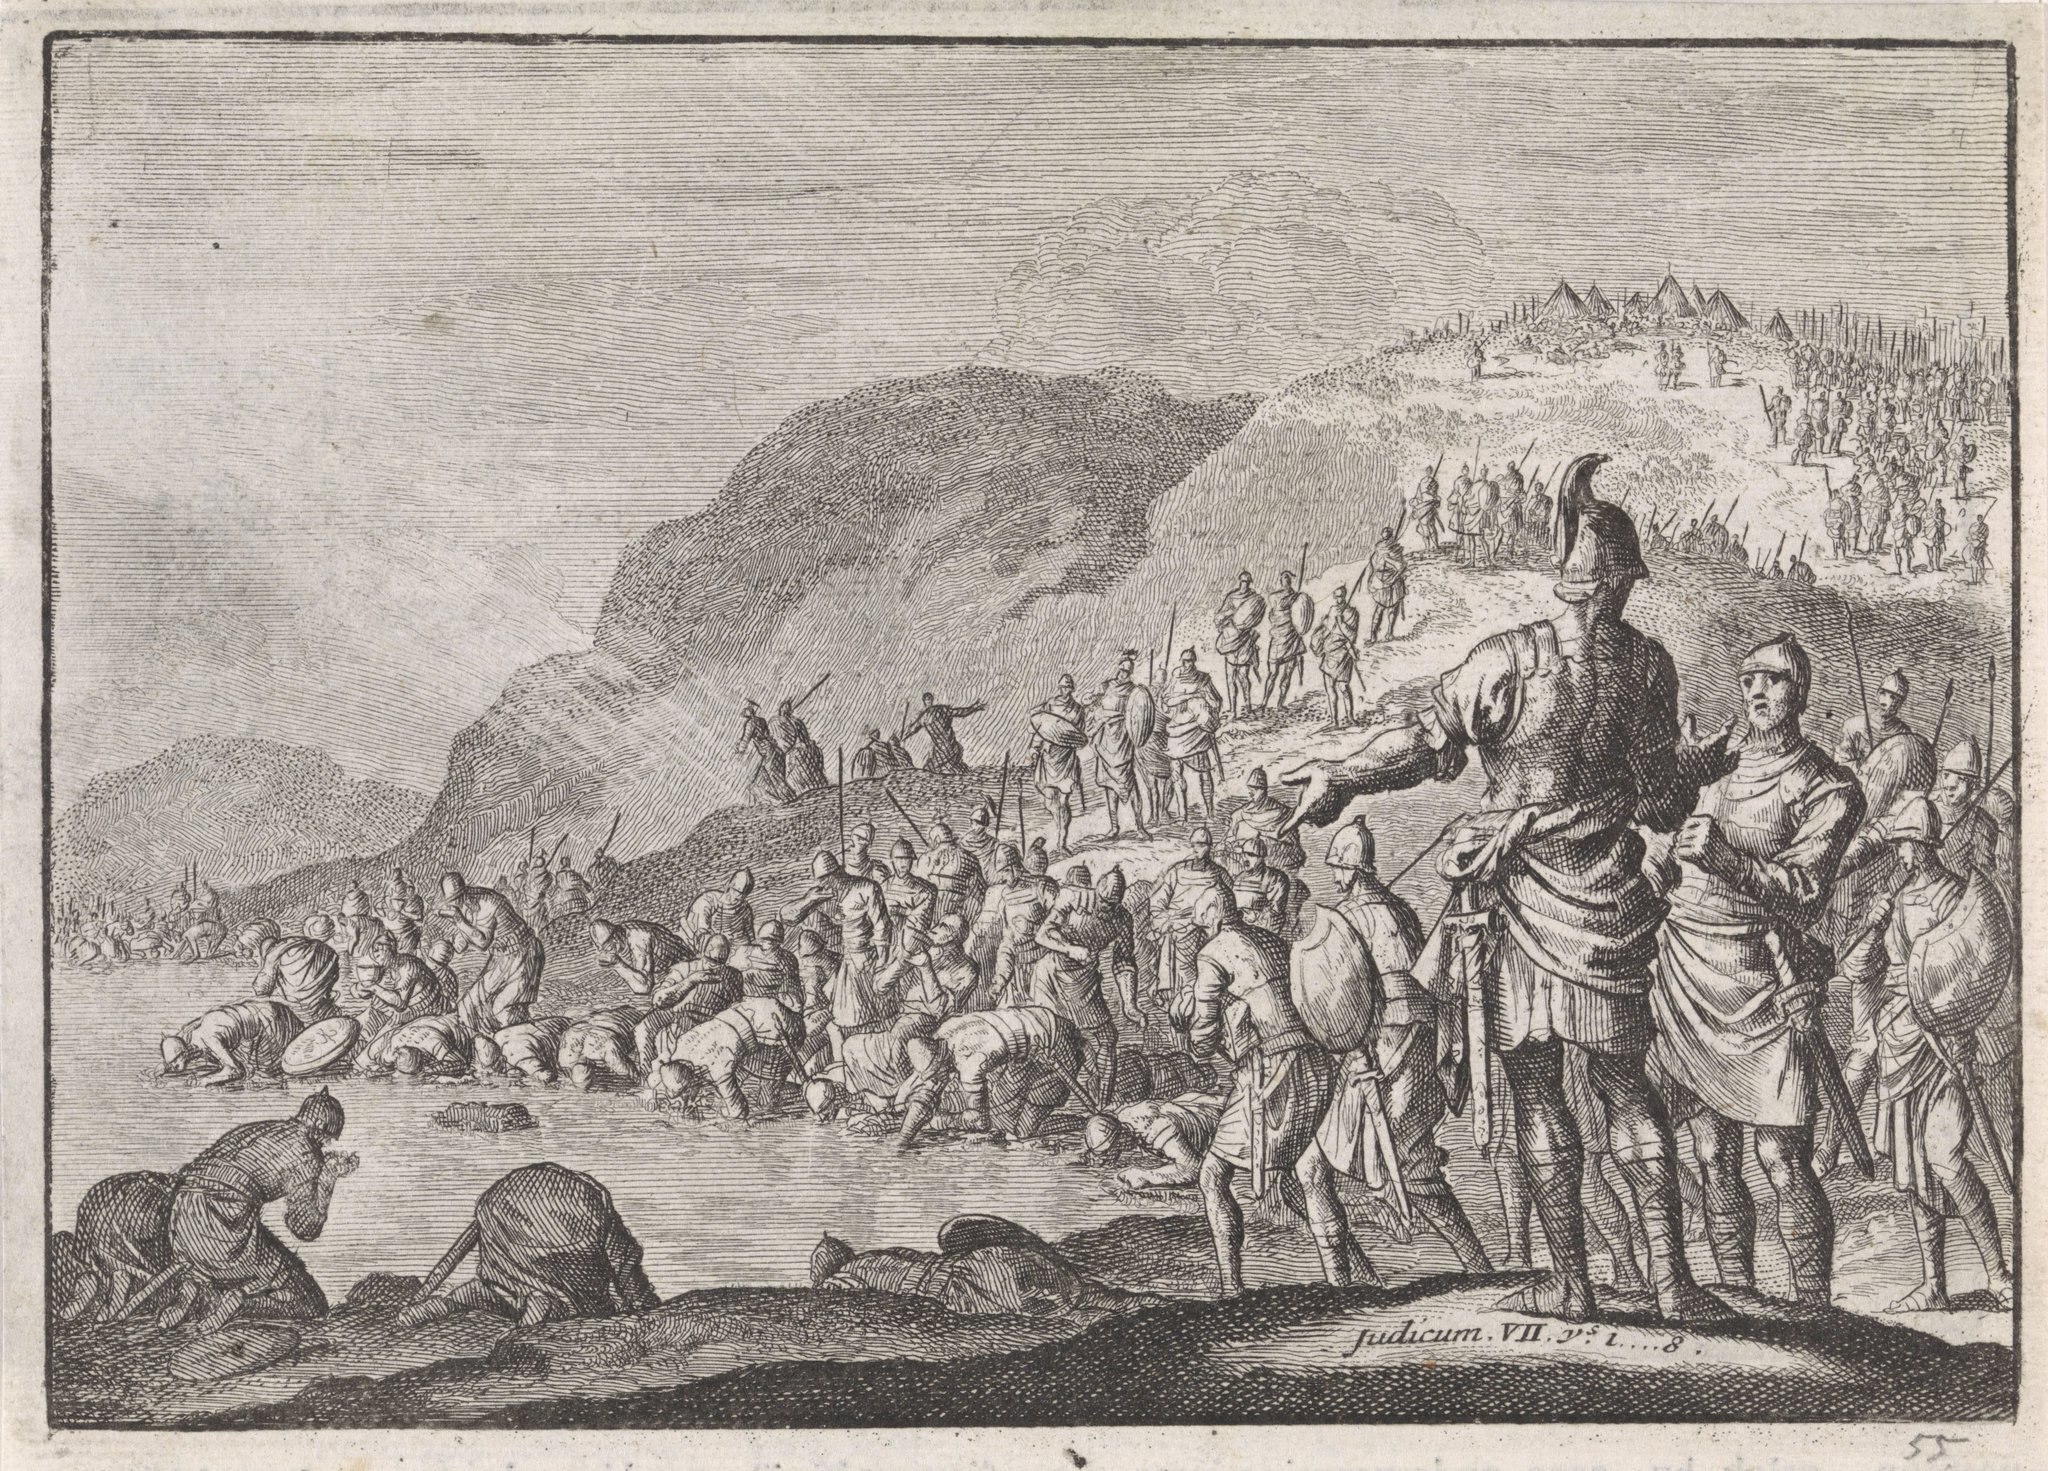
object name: print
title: Gideon beveelt zijn manschappen water te drinken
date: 1703-1762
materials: paper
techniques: etching, letterpress printing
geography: amsterdam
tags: those who lap water by putting their hand to their mouth are separated from those who kneel down to drink the water ~ selection of gideon's men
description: De prent komt een eerste keer voor als boekillustratie voor David Martin. Historie des Ouden en Nieuwen Testaments. Amsterdam, Pieter Mortier, 1703. Deel I. De boekillustraties voor de Mortierbijbel hebben verschillende staten en kopieën, waarbij de chronologische volgorde moeilijk te achterhalen valt. Als boekillustraties werden ze bovendien herhaaldelijk opnieuw gebruikt voor andere boekwerken.